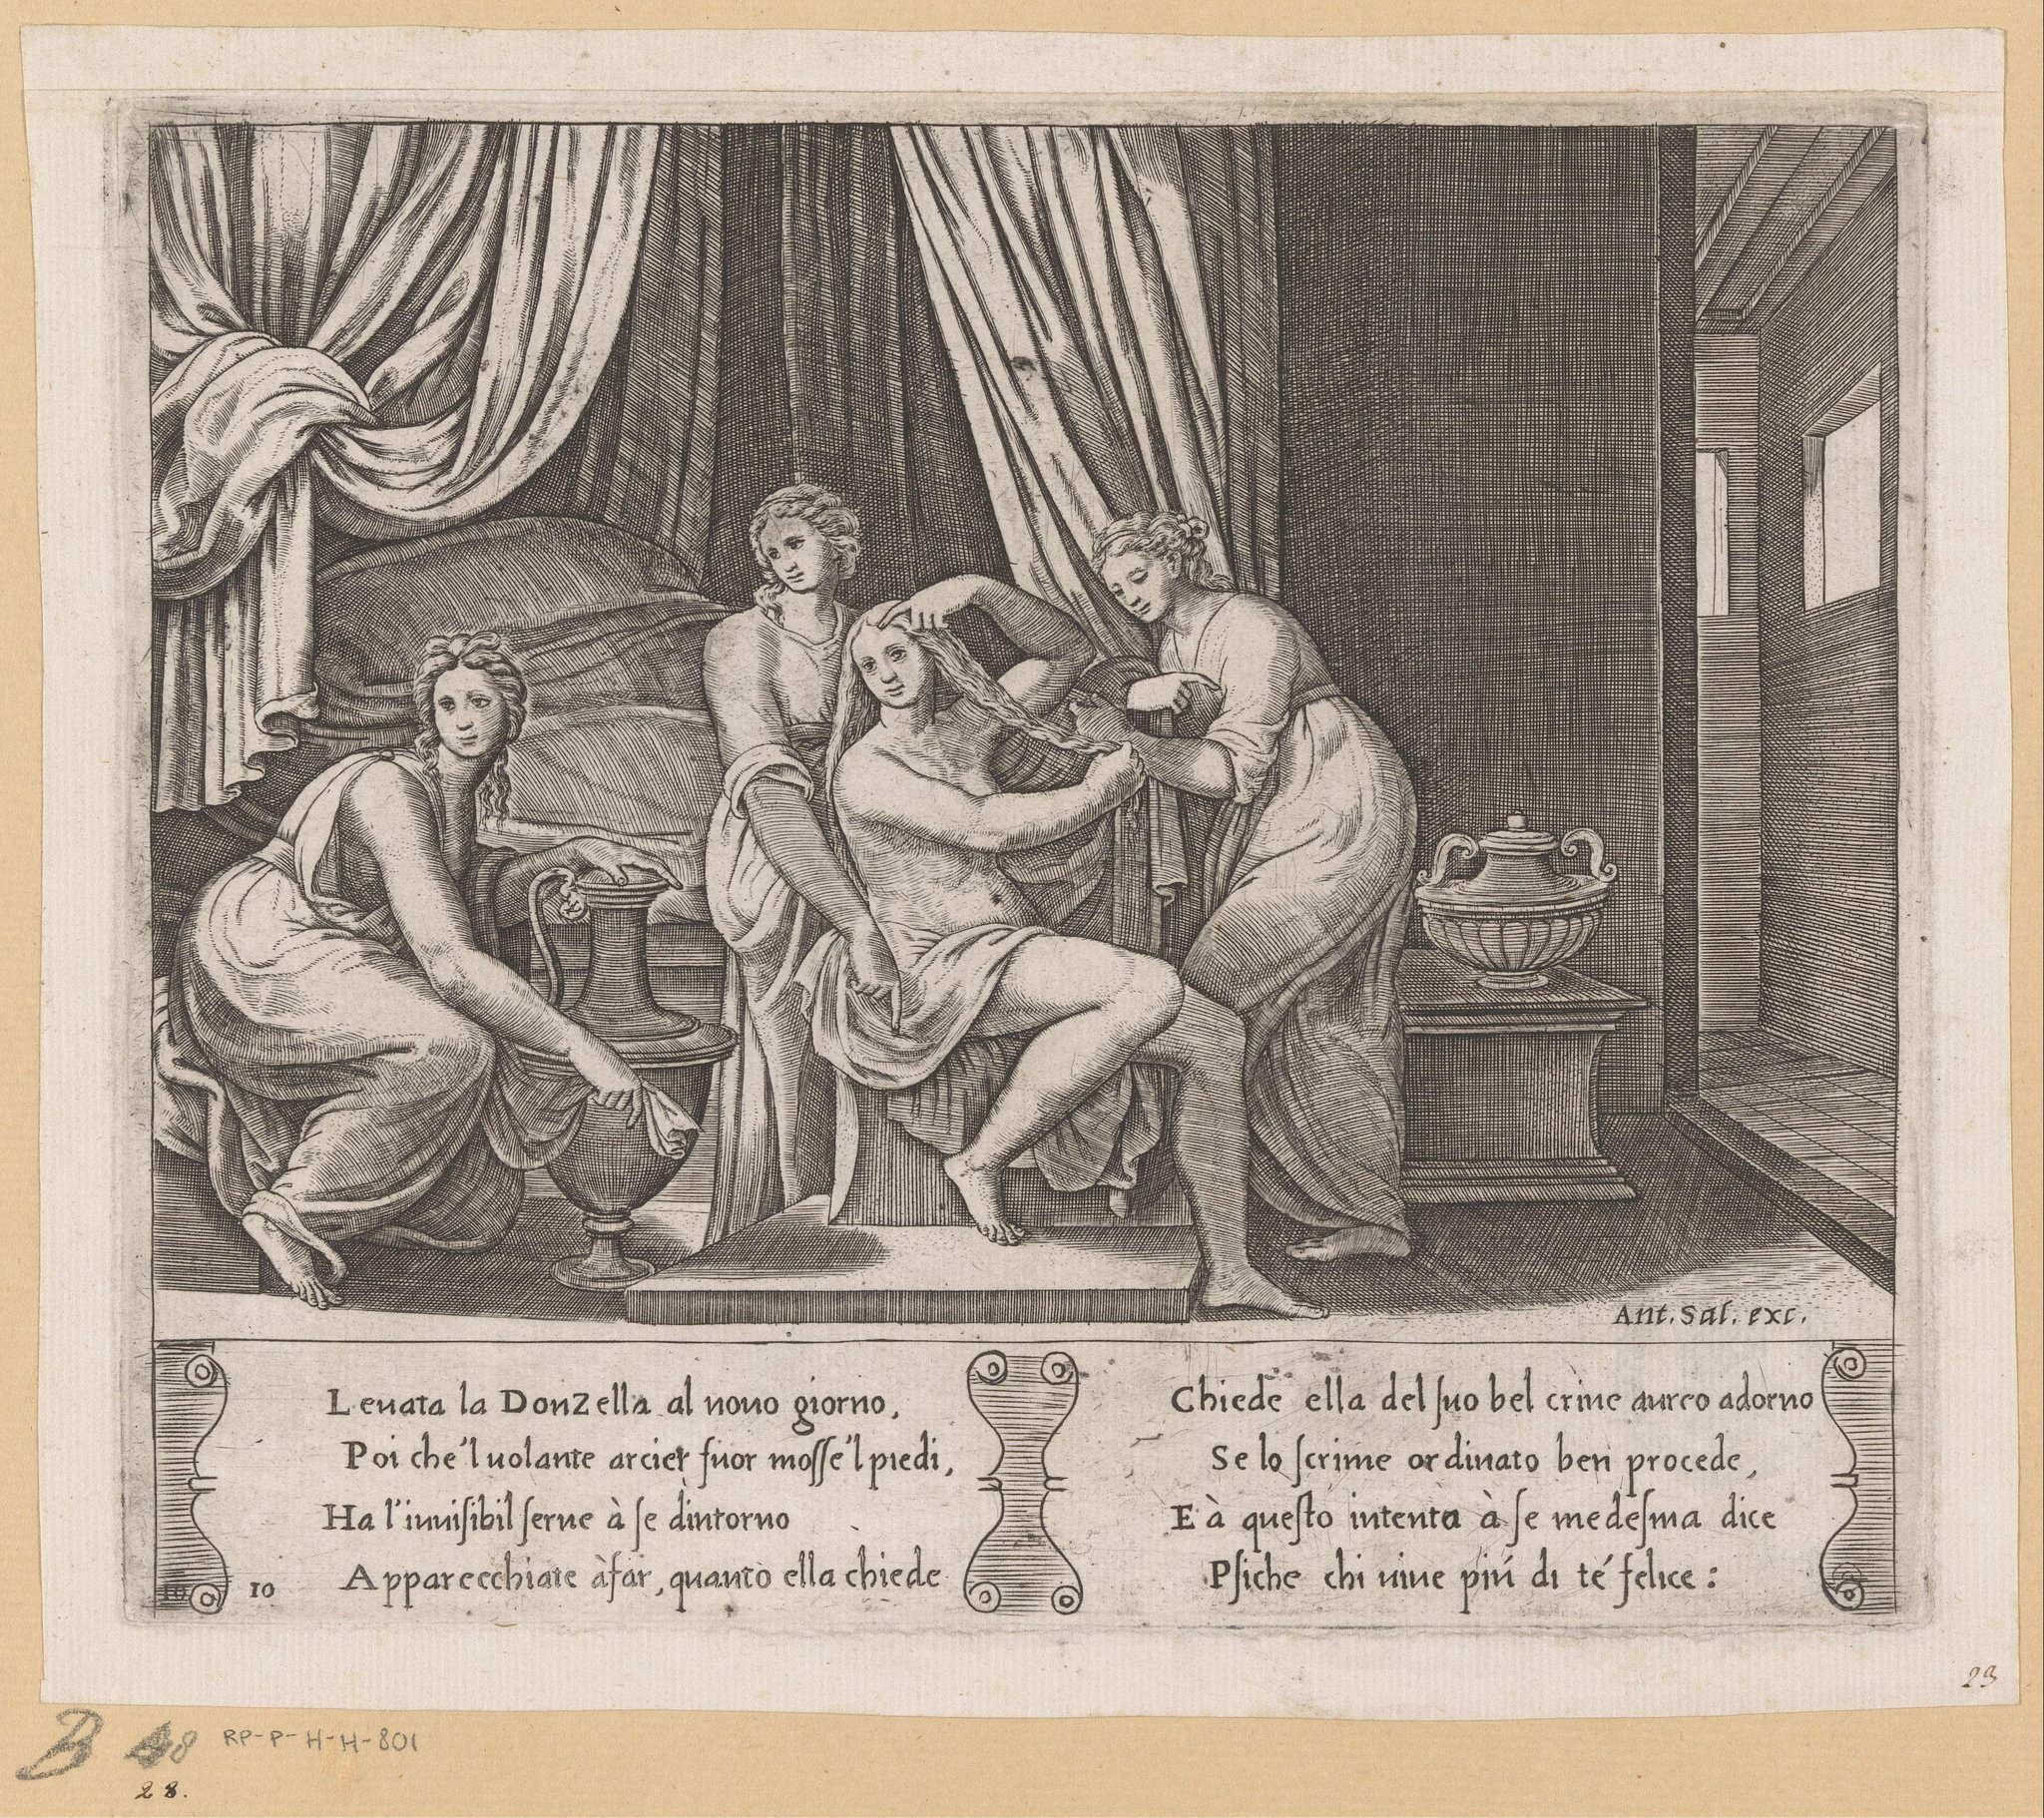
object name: print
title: Toilet van Psyche met nimfen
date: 1530-1560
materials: paper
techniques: engraving, intaglio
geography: italy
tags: psyche is attended by invisible hands; the toilet of psyche, nymphs (in general); 'ninfe in commune' (ripa)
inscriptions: collector's mark: Lugt 11, collector's mark: Lugt 10, number: ‘23’, collector's mark: ‘Hinloopen’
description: Prent uit een serie met scènes uit het verhaal van Amor en Psyche naar ontwerp van Michiel Coxie, waarvan 29 prenten door de Meester van de Dobbelsteen en 3 door Agostino Veneziano.